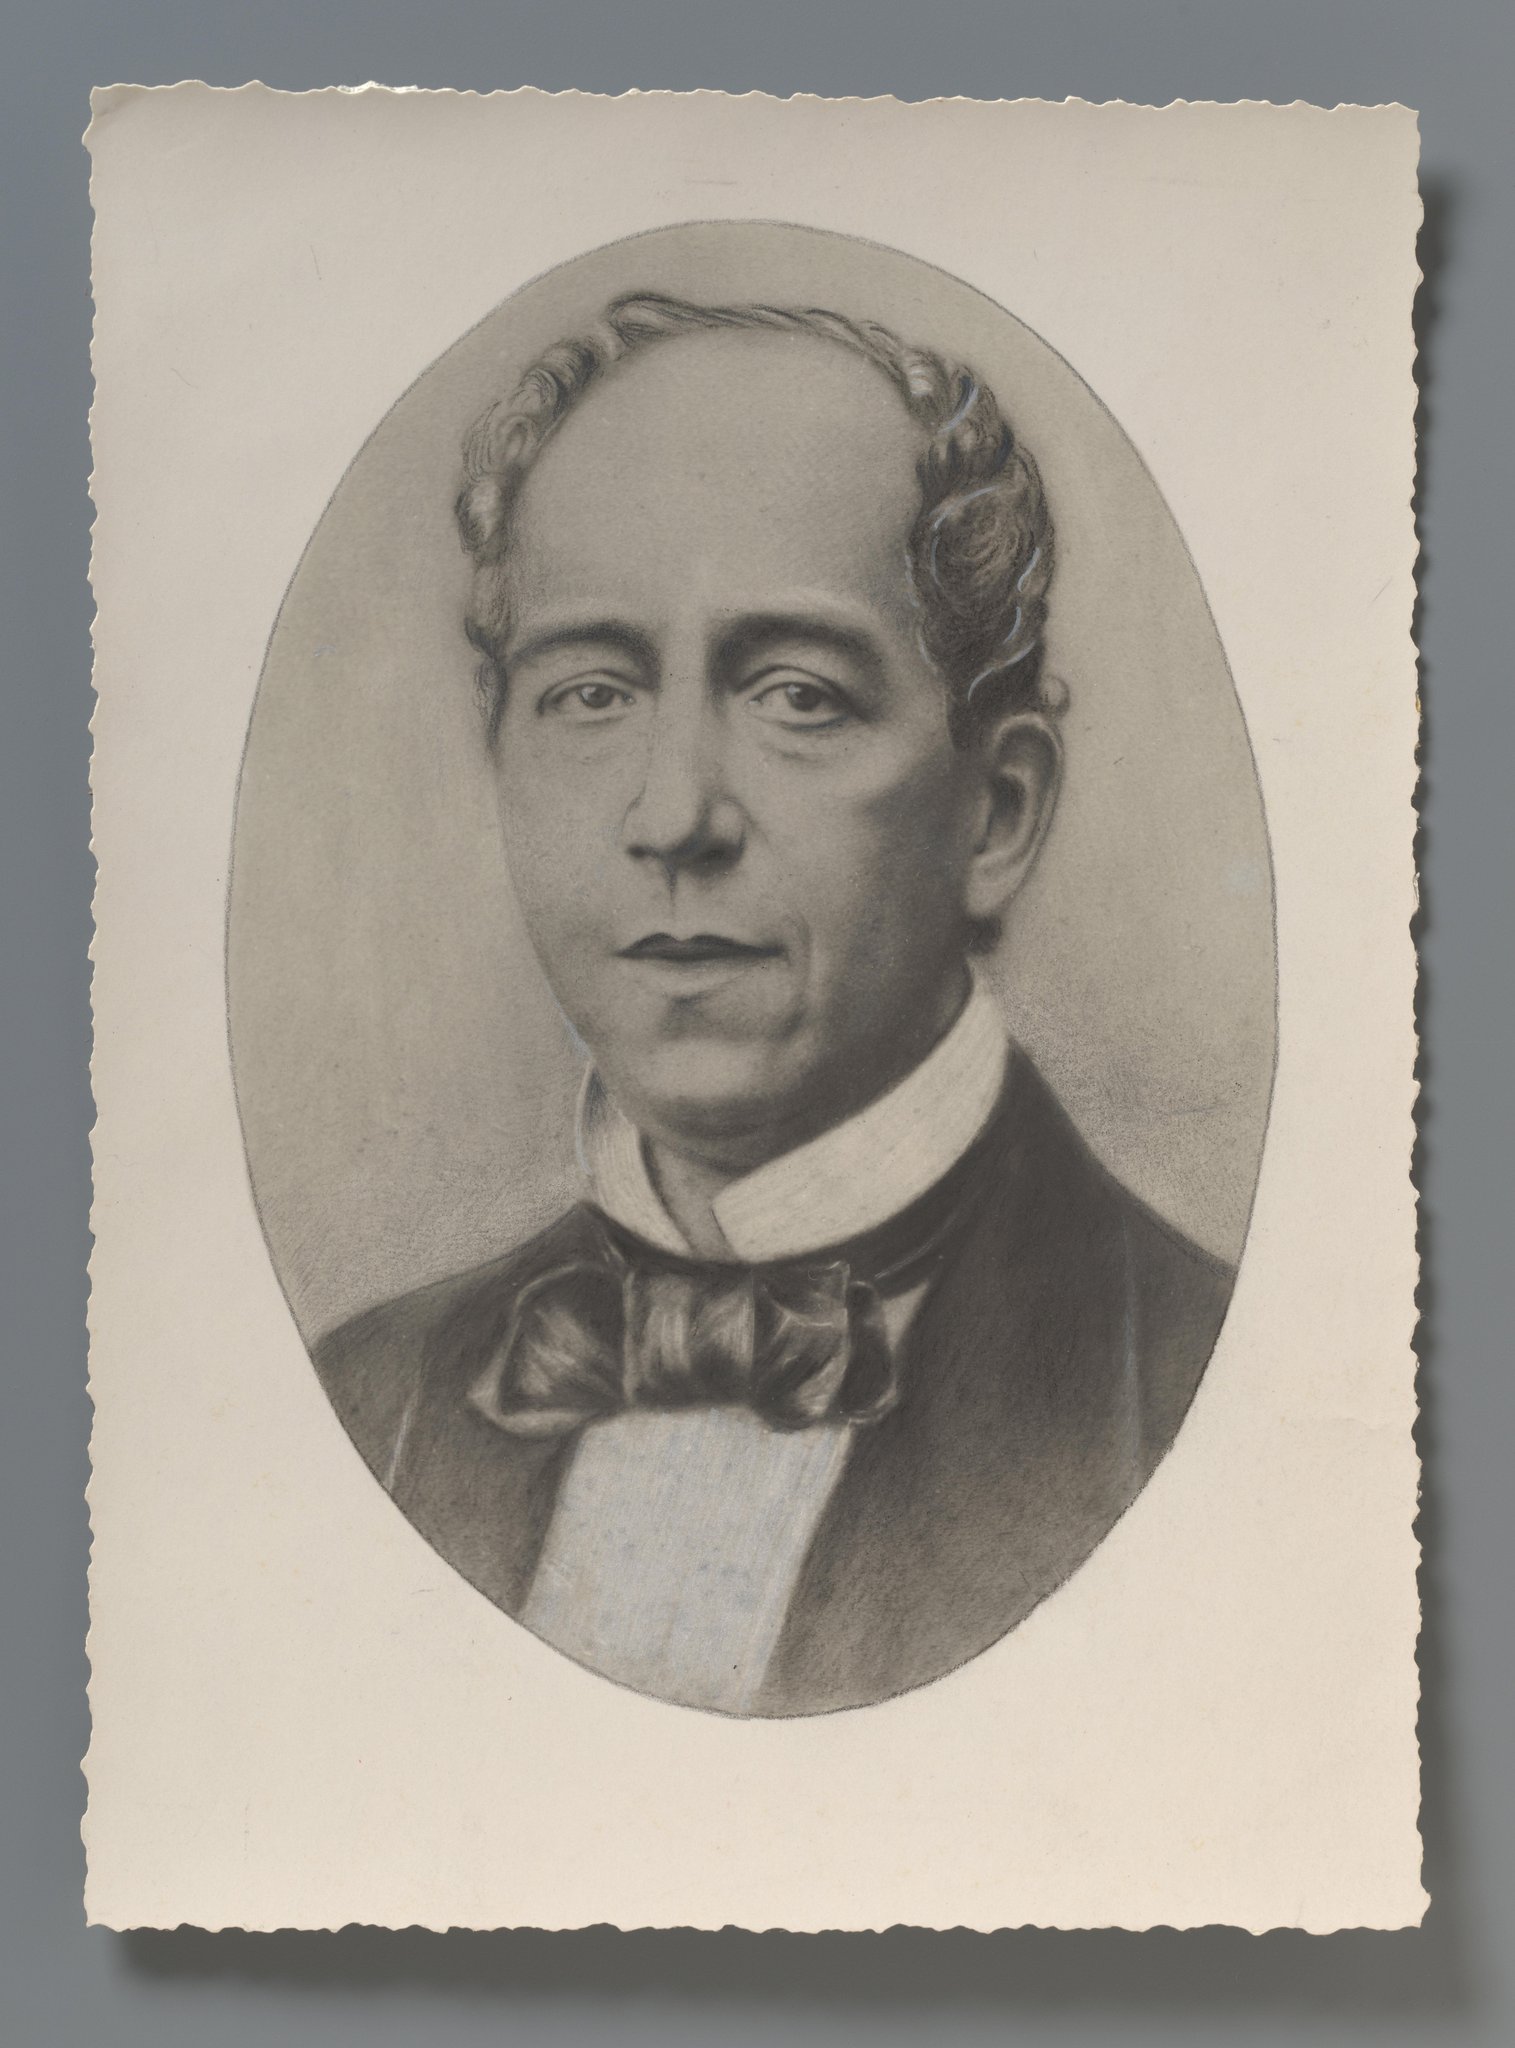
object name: photograph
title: Portrait of a Couple in Suriname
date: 1920-1930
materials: photographic support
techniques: gelatin silver print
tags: marriage, married couple, 'matrimonium'